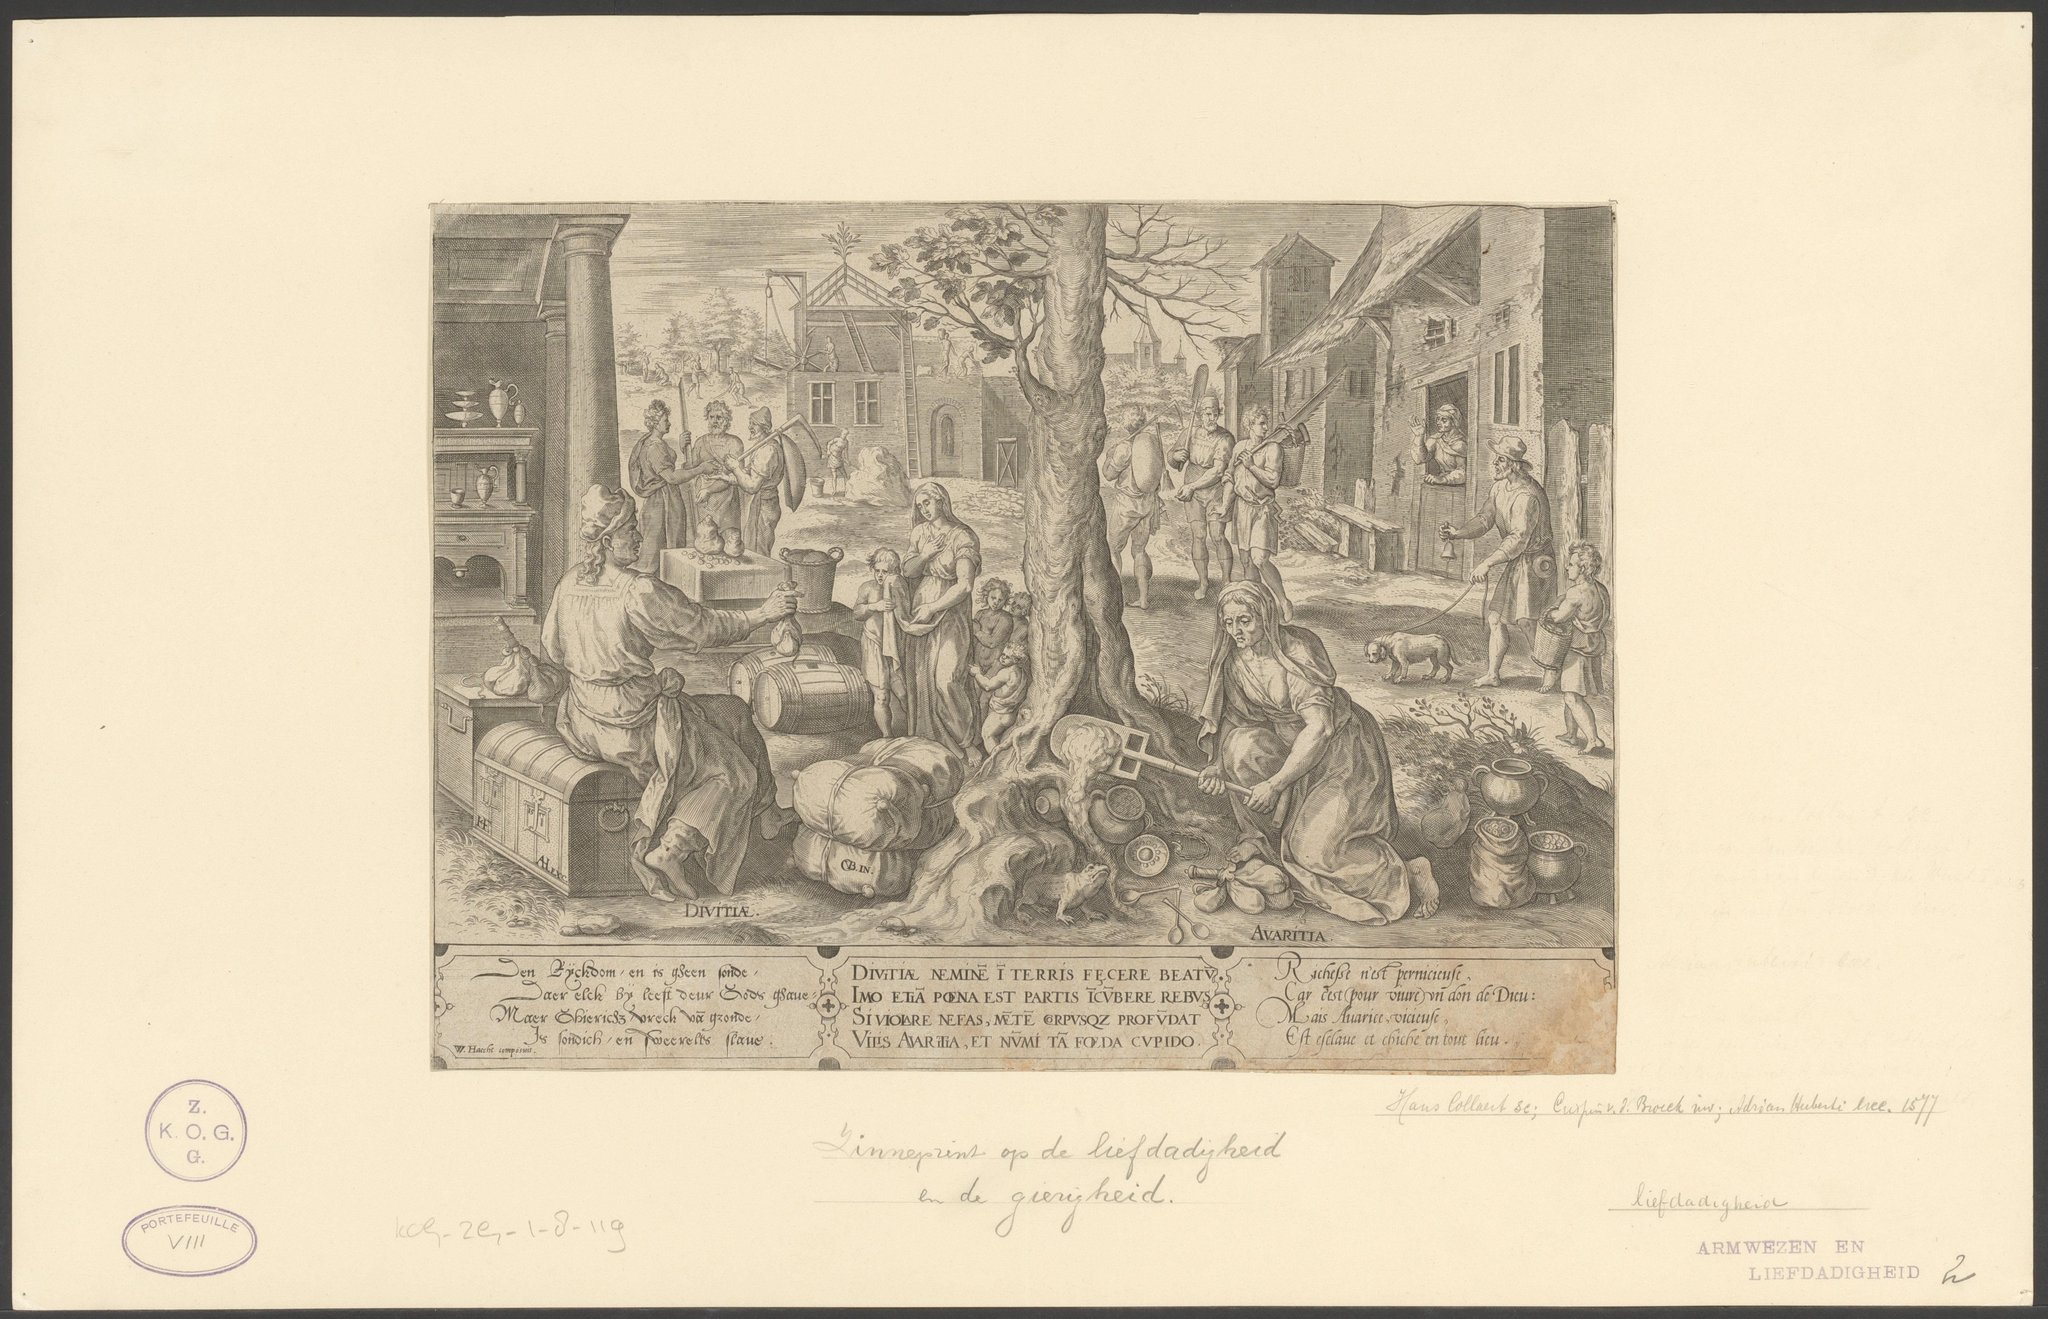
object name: print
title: Gierigheid, het gevaar van rijkdom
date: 1577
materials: paper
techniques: engraving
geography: antwerp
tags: covetousness; 'avaritia' (ripa) ~ personification of one of the seven deadly sins, working class, labourers, wealth, opulence; 'opulenza', 'richezza' (ripa), building-site, beggar, charitable works, topping out, celebration of the erection of the roof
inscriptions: collector's mark, collector's mark: Lugt 1641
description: Op de voorgrond links Rijkdom (Divitiae), omringd door geldkisten en voorraadgoederen. Gekleed als handelaar houdt hij een geldbuidel in zijn rechterhand, die hij een vrouw en haar gezin aanreikt. Rechts op de voorgrond Gierigheid (Avaritia). Zij is gekleed als een oude vrouw en begraaft haar schatten onder een boom. Op de achtergrond links de bouw van een huis met overal vlijtige werkers. Rechts een krottenbuurt met bedelaars. De prent heeft een onderschrift in Nederlands, Latijn en Frans in verzen. De verzen loven rijkdom als het gebruik van Gods gaven, ze veroordelen echter de gierigheid als een zware zonde. Onderwerpsrubrieken binnen de Atlas Zeden en Gewoonten: Armwezen en Liefdadigheid.